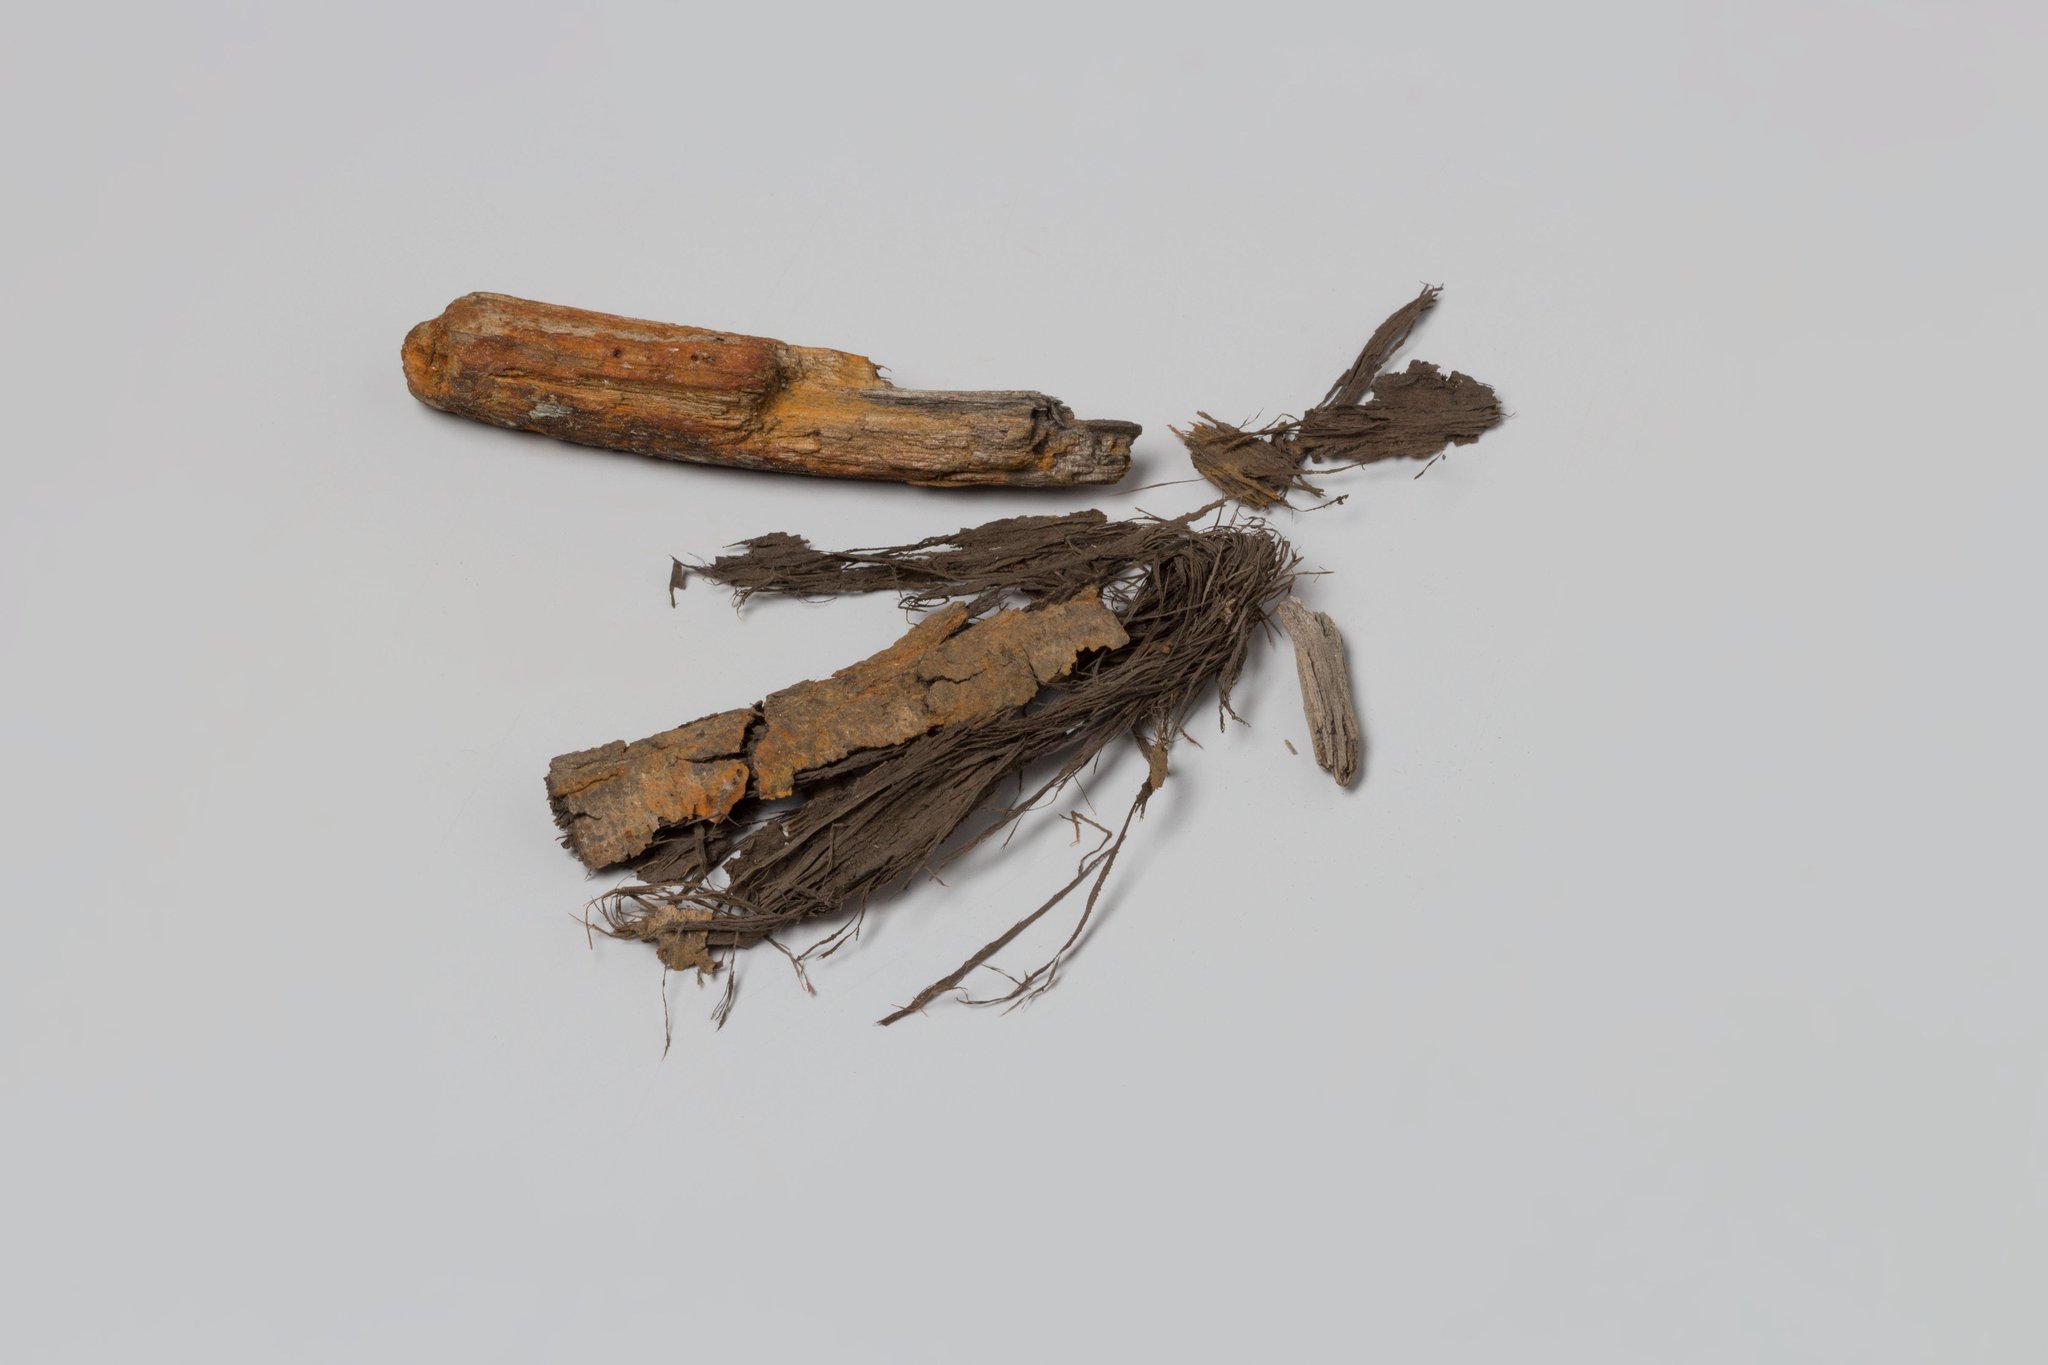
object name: spike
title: Fragment van een houten pin en een bundeltje vezels, mogelijk een lont, uit het wrak van de in 1735 vergane Oost-Indiëvaarder 't Vliegend Hart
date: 1700-1735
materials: wood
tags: 't vliegend hart (schip), verenigde oostindische compagnie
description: Nader te determineren houen pen en vezelbundel.